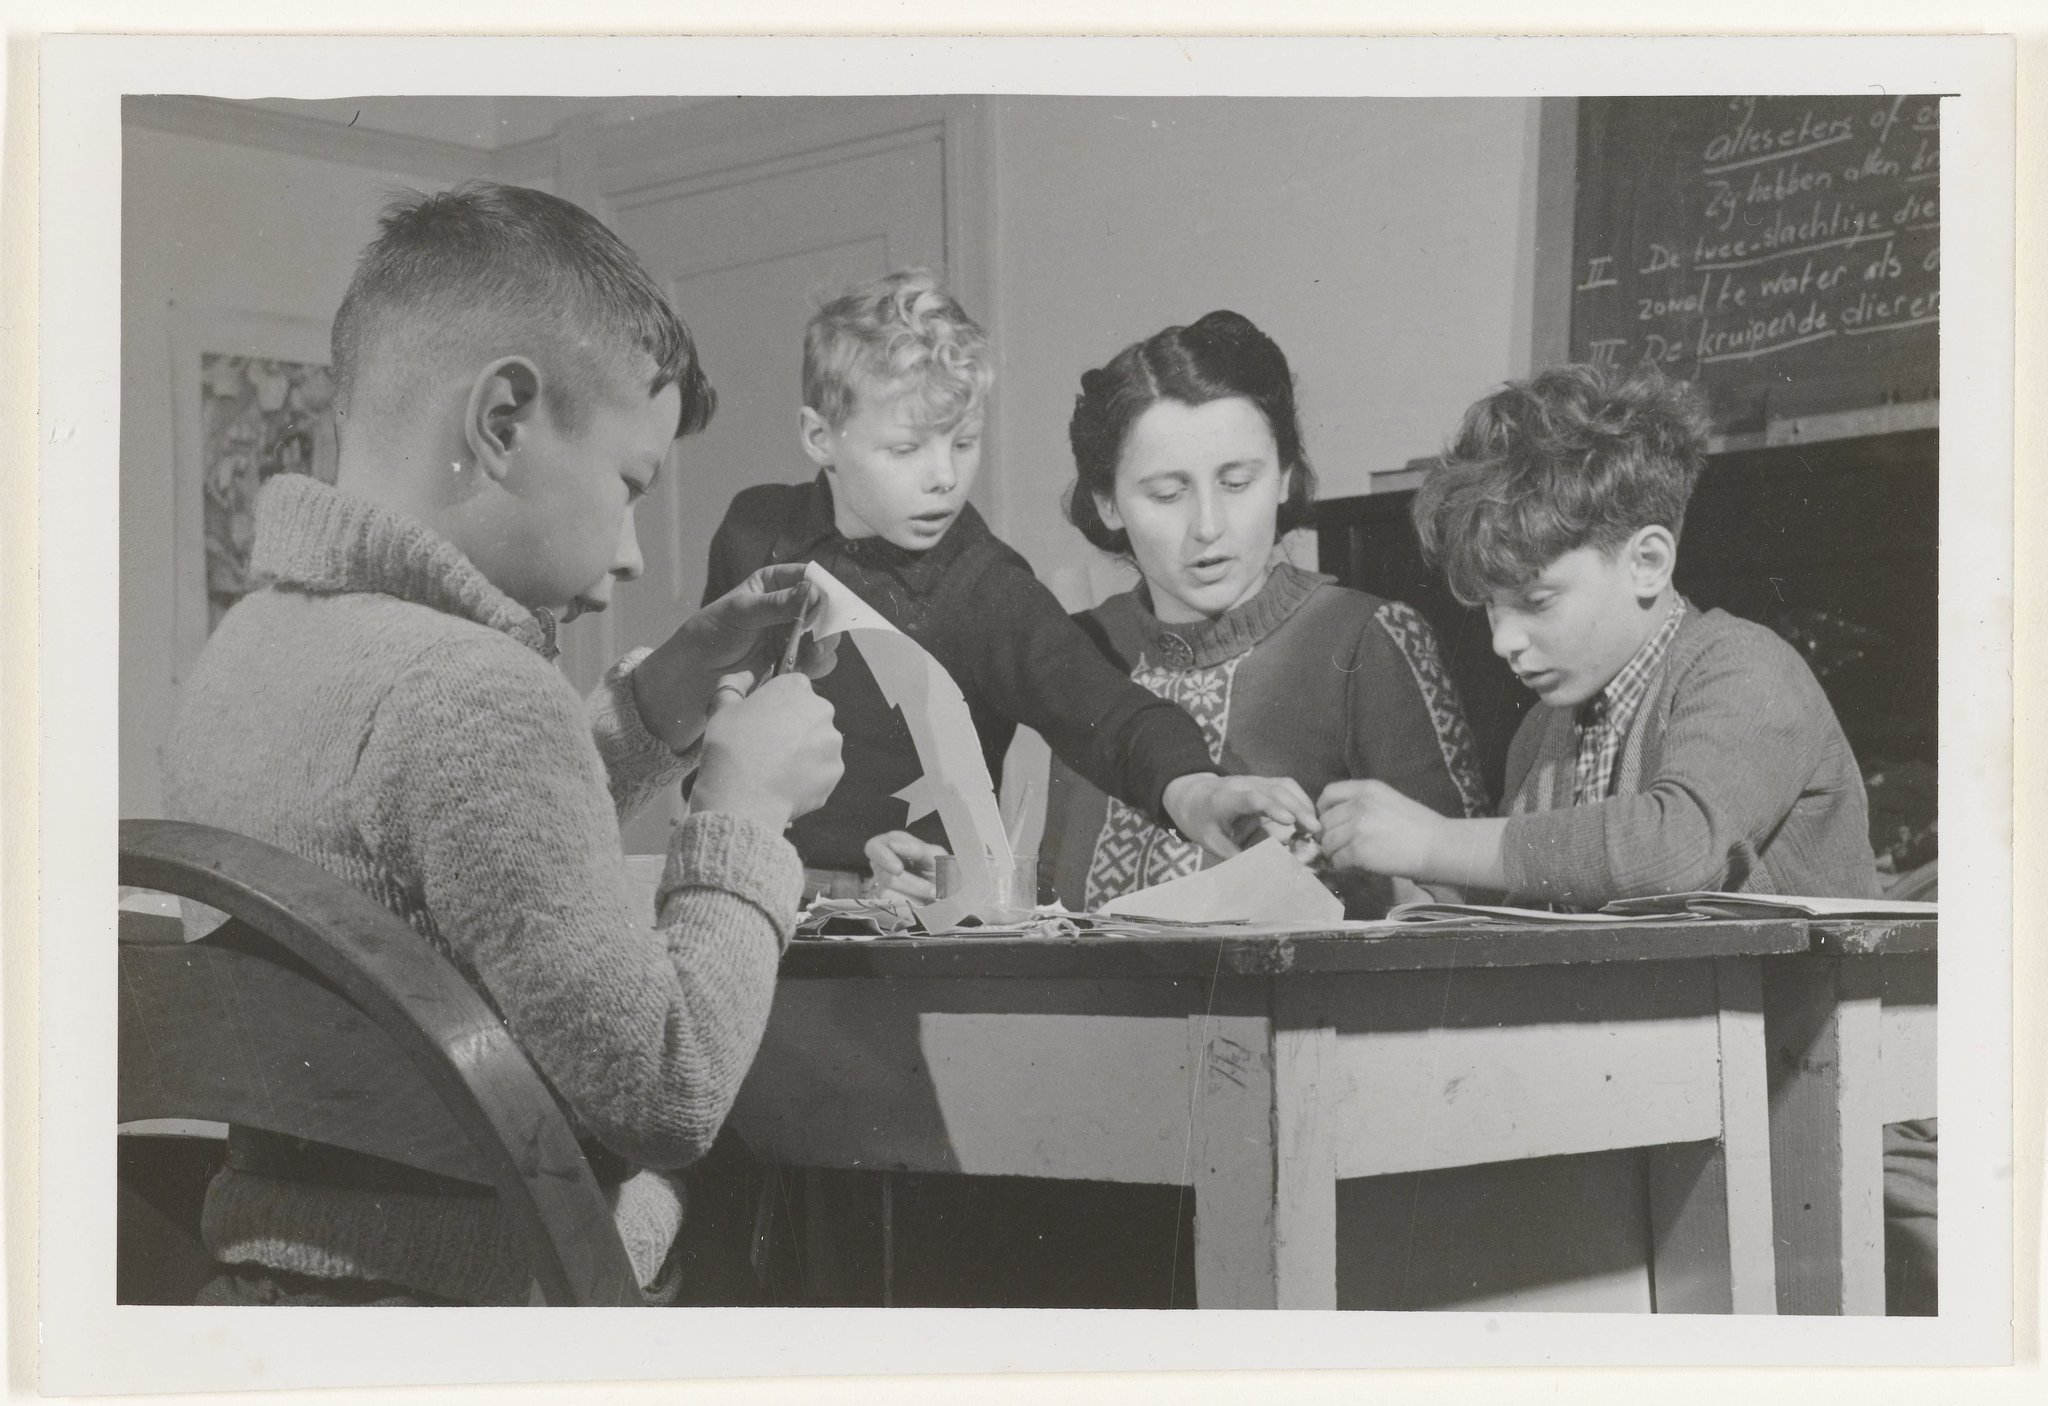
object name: photograph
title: Leerlingen van de Werkplaats Kindergemeenschap Bilthoven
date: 1946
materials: photographic support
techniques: photography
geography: bilthoven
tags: amsterdam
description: Leerlingen van de Werkplaats Kindergemeenschap Bilthoven, ook genoemd de Werkplaats Kees Boeke. De leerlingen zijn bezig met een plak-en kniples.